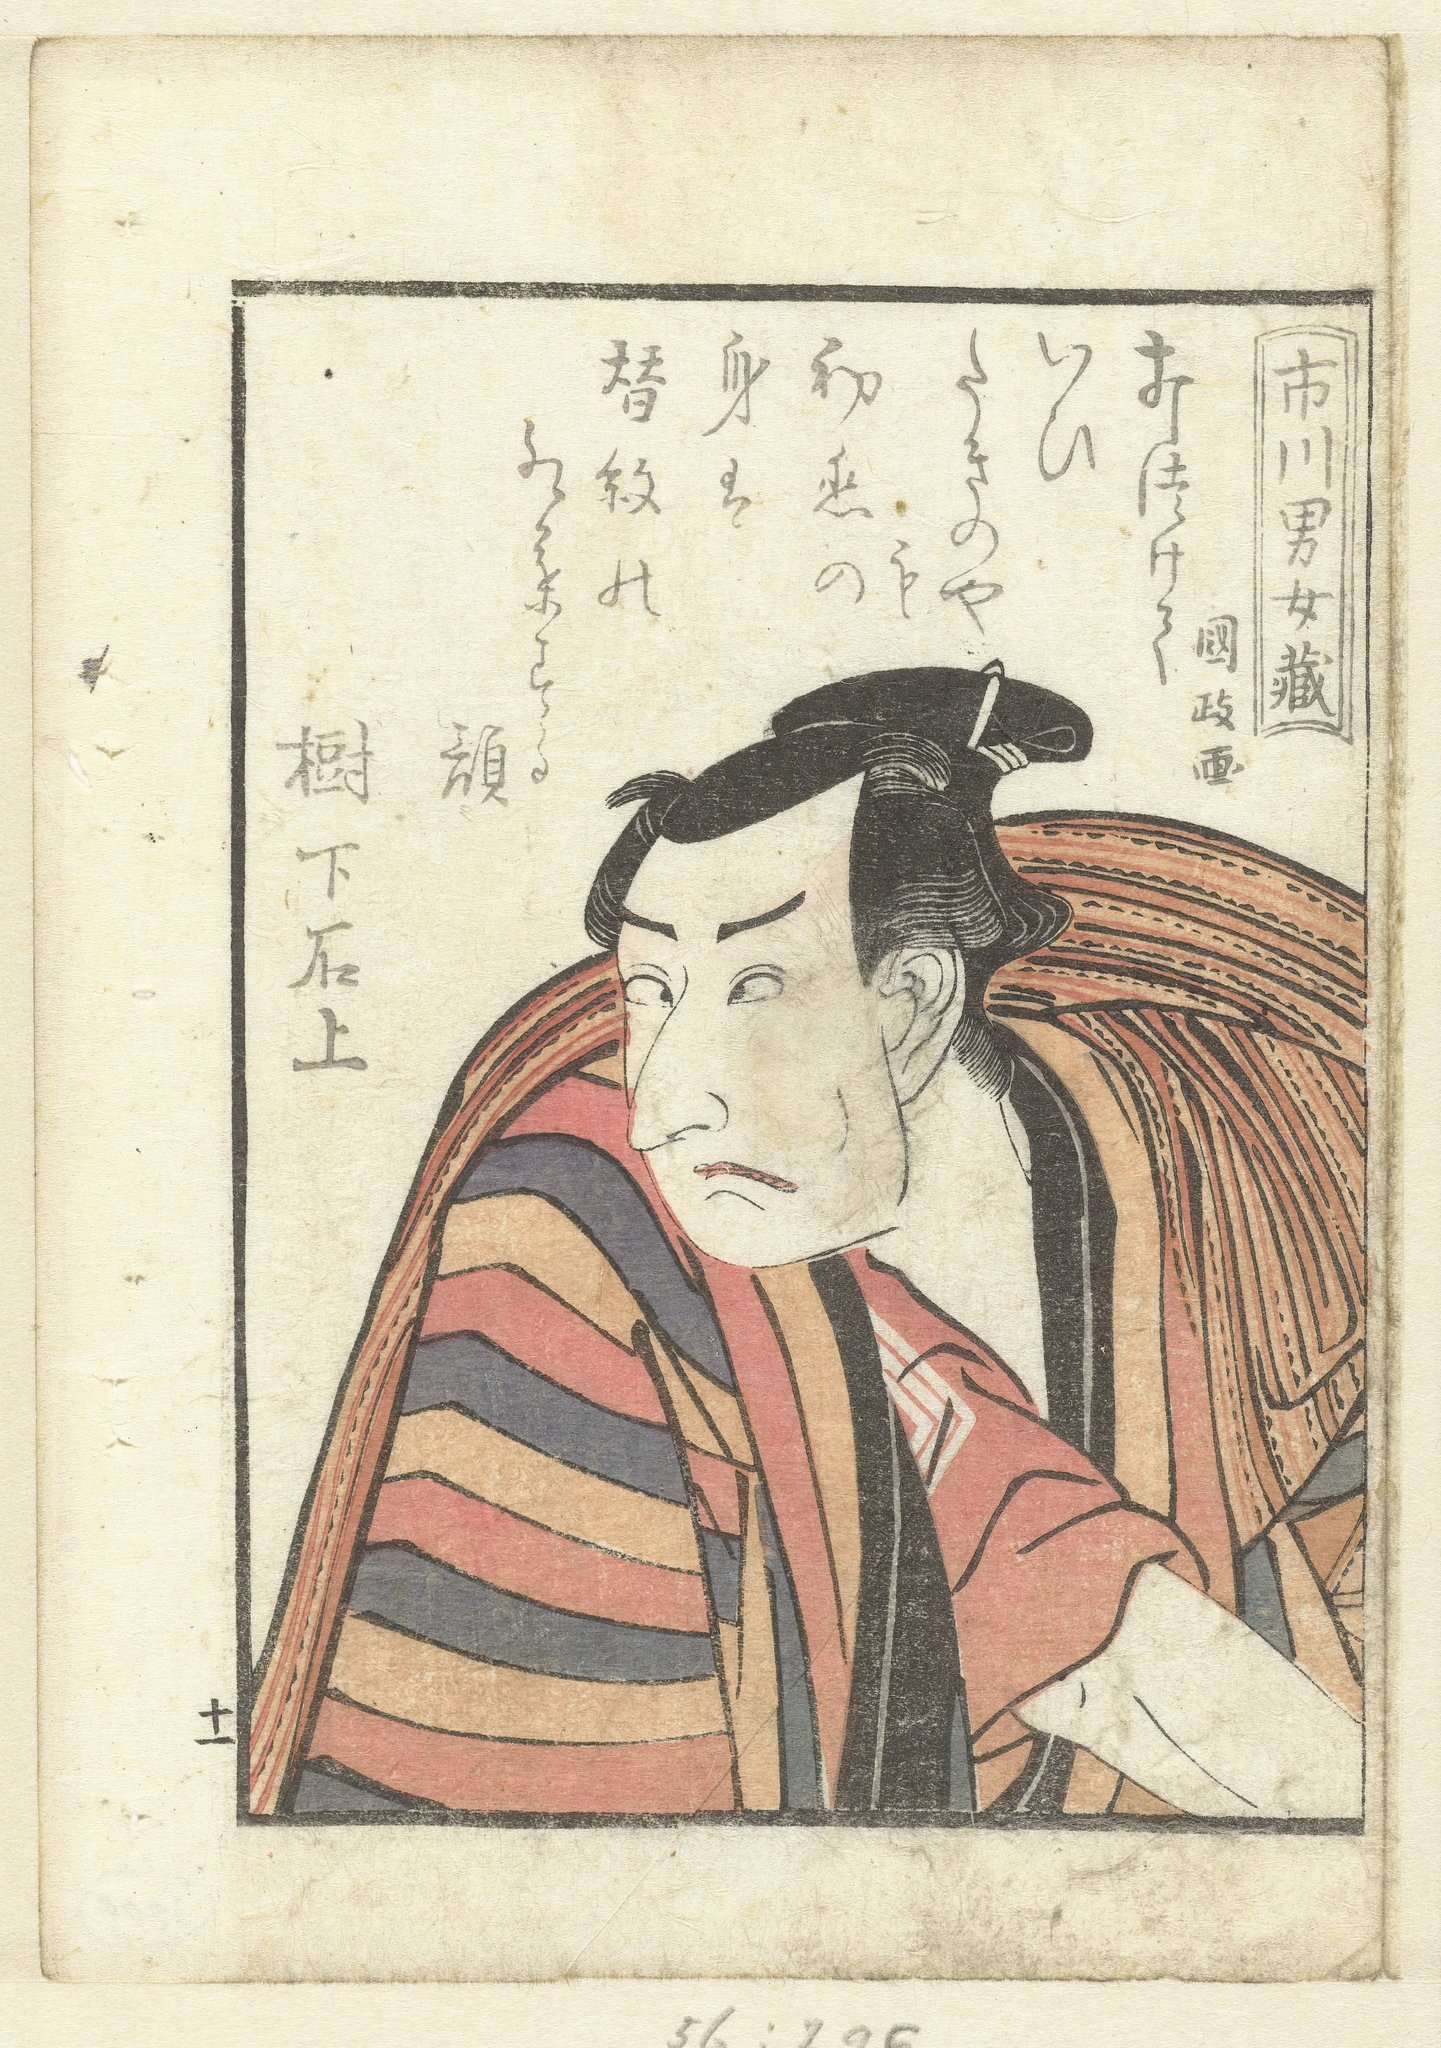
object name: print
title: Blad uit het boek Haiju raku Hotsu (toneelspelers van Yedo) 1799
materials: paper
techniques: woodcut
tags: portrait of actor, actress